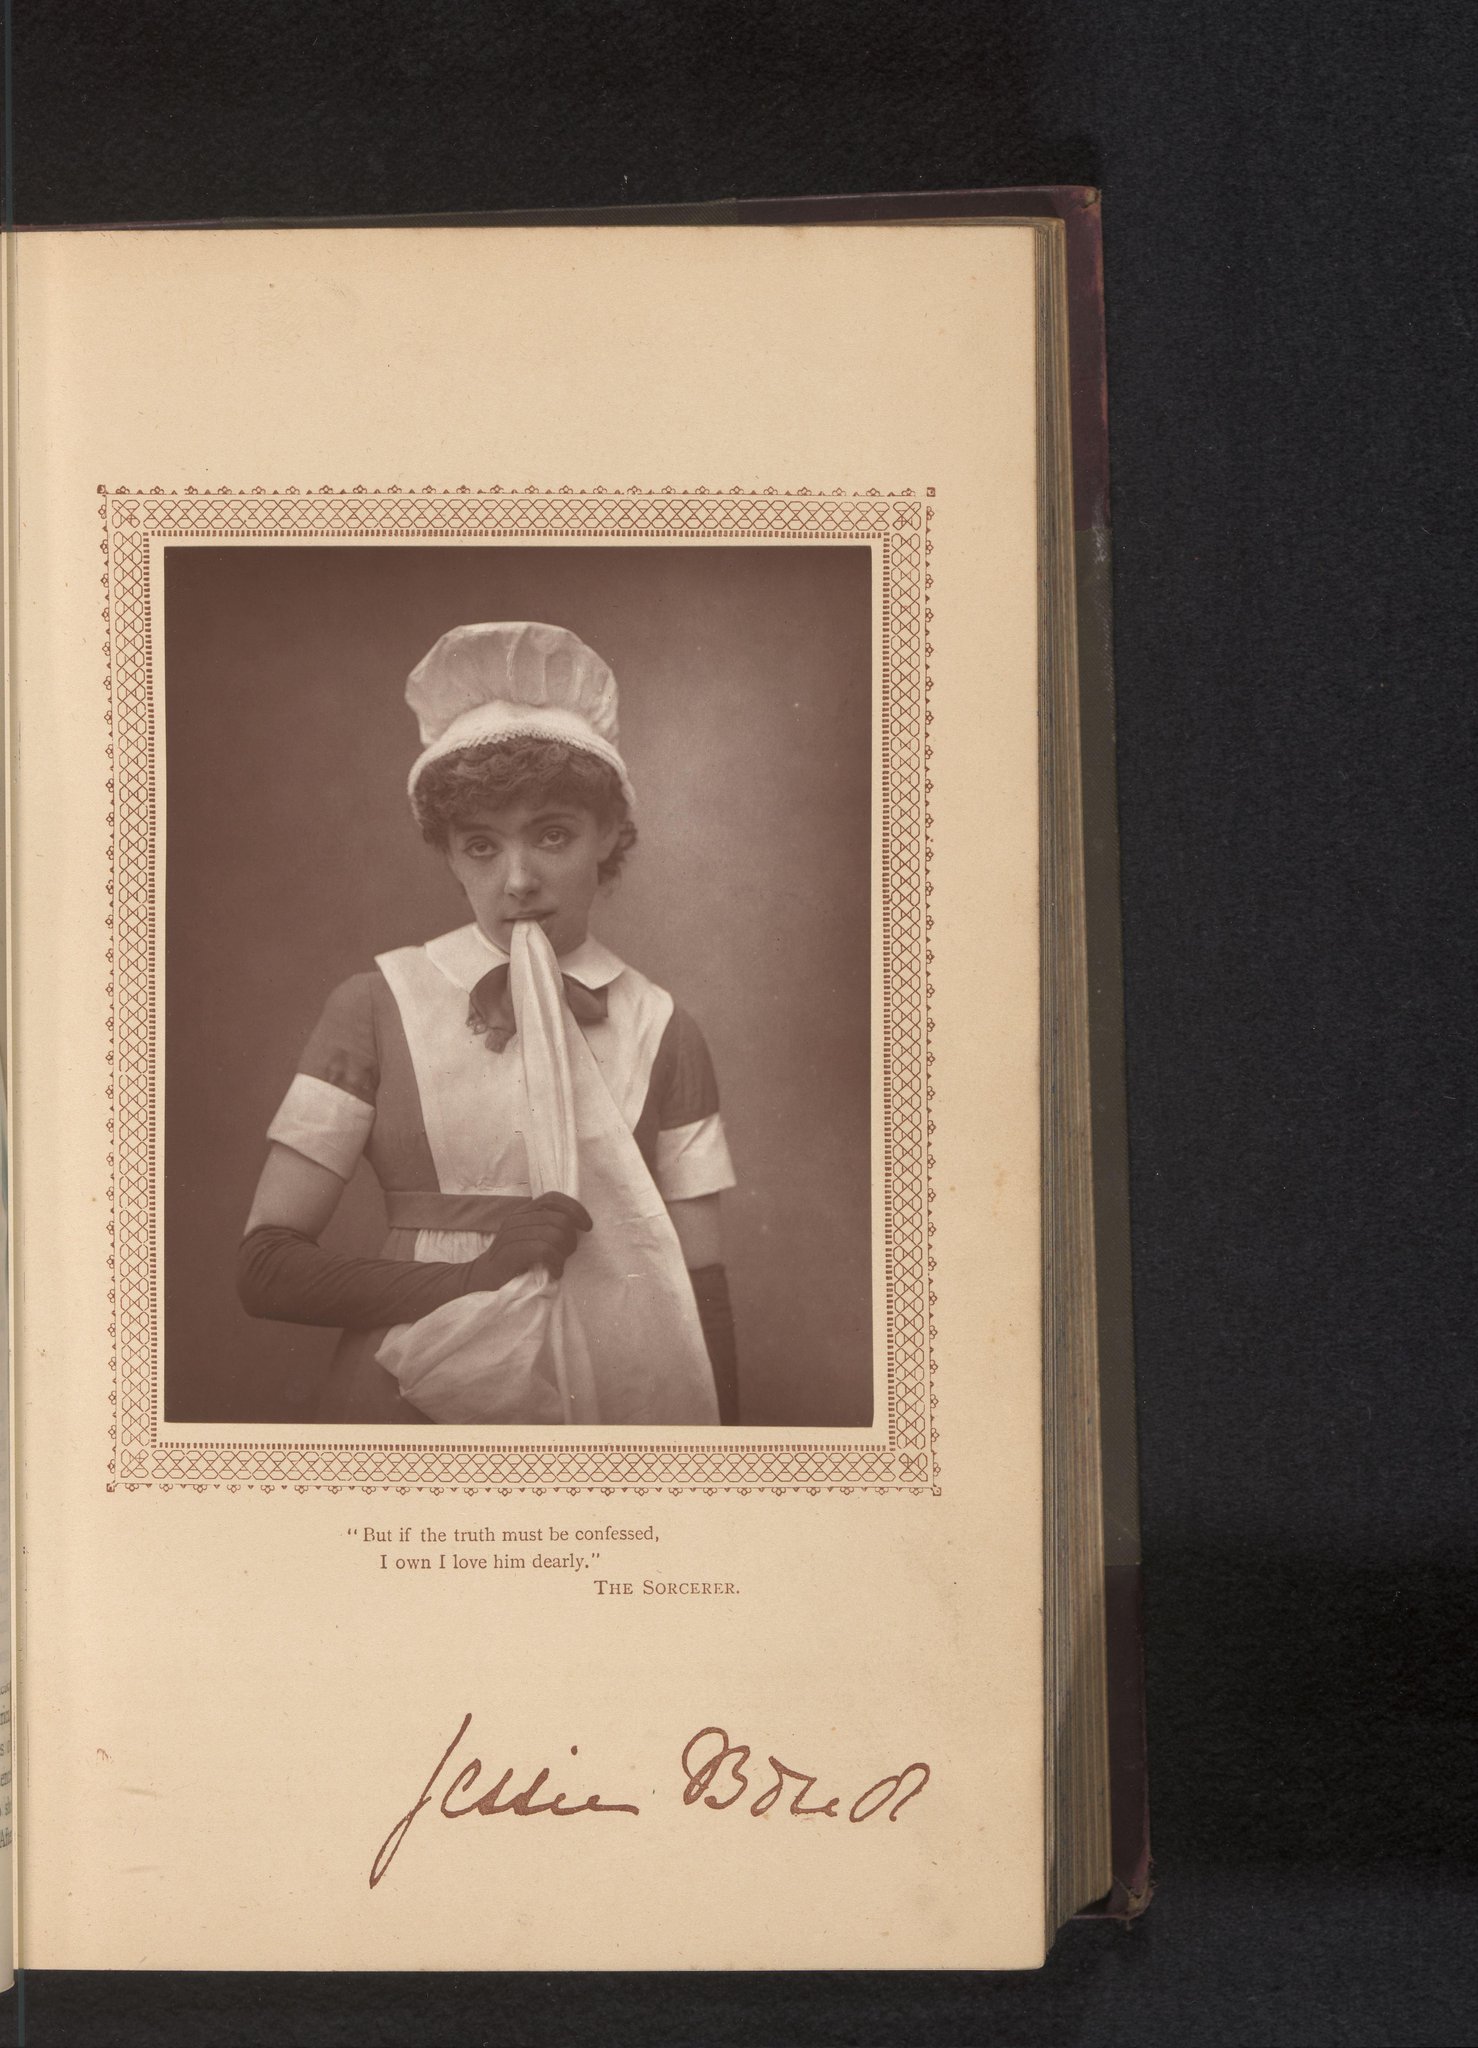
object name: photomechanical print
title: Portret van Jassie Bond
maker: Anonymous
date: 1880-1885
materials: paper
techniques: woodburytype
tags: adult man, historical persons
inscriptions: signature: ‘Jessie Bond’, inscription: ‘'But if the truth must be confessed,/ I own I love him dearly.'/ The Sorcerer’